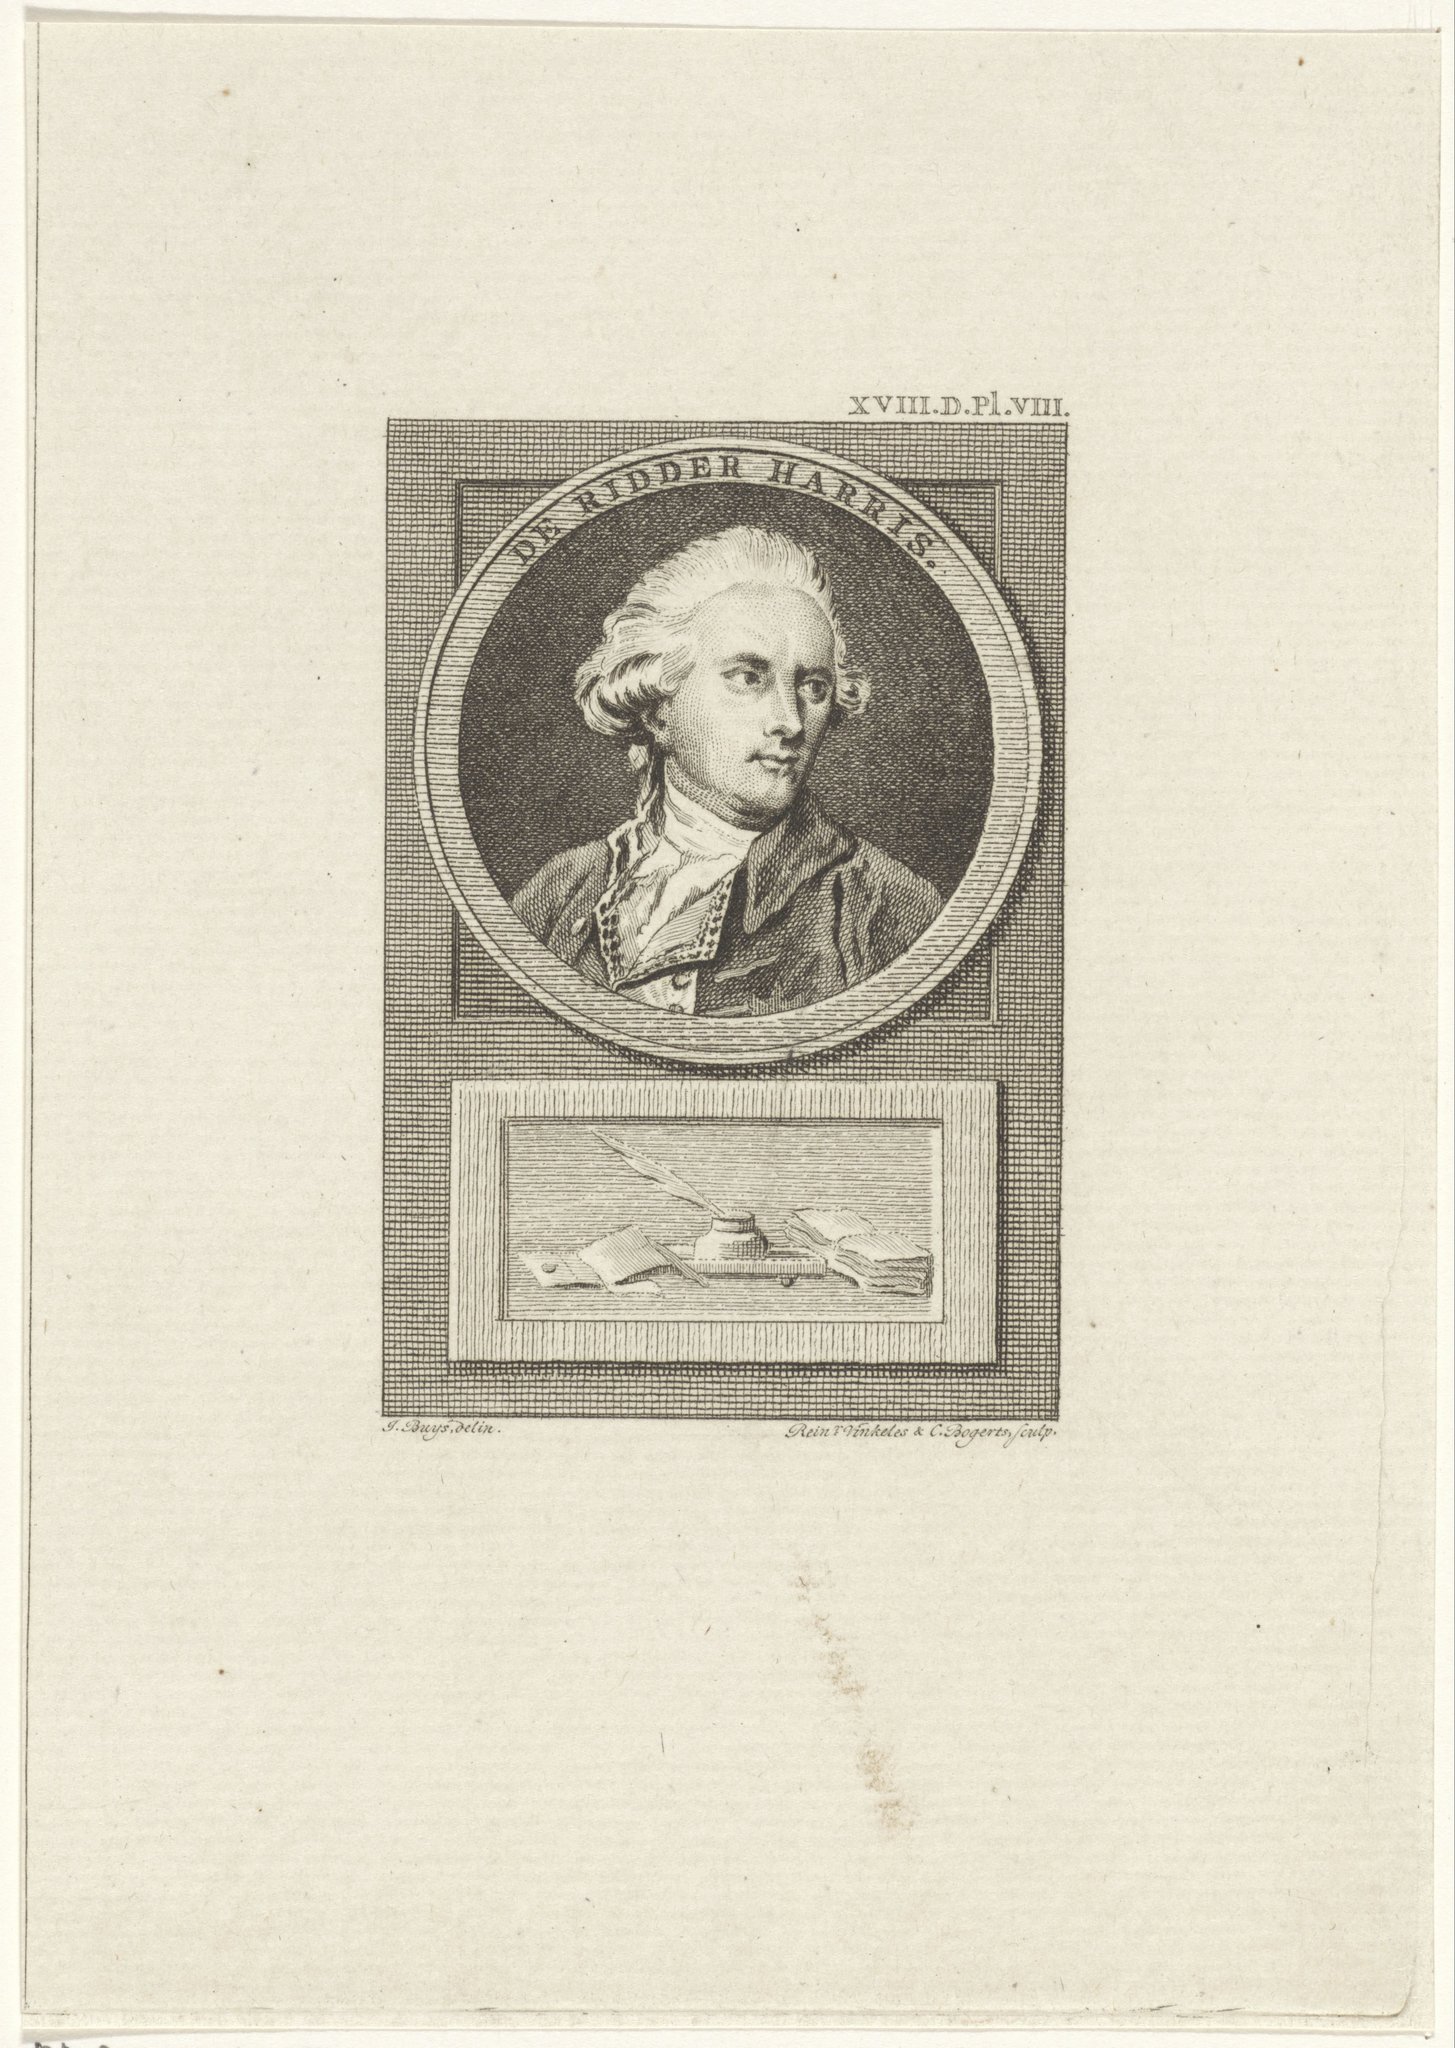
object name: book illustration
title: Portret van ridder Harris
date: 1783-1795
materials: paper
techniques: engraving, etching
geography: amsterdam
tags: quill, ink-well, letter, envelope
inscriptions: collector's mark: Lugt 2228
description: Prent gebruikt in: Fokke, Jan. Geschiedenissen der Vereenigde Nederlanden voor de vaderlandsche jeugd Ie-XXVste deel. Amsterdam: Johannes Allart, 1783-1795. Deel XVIII.